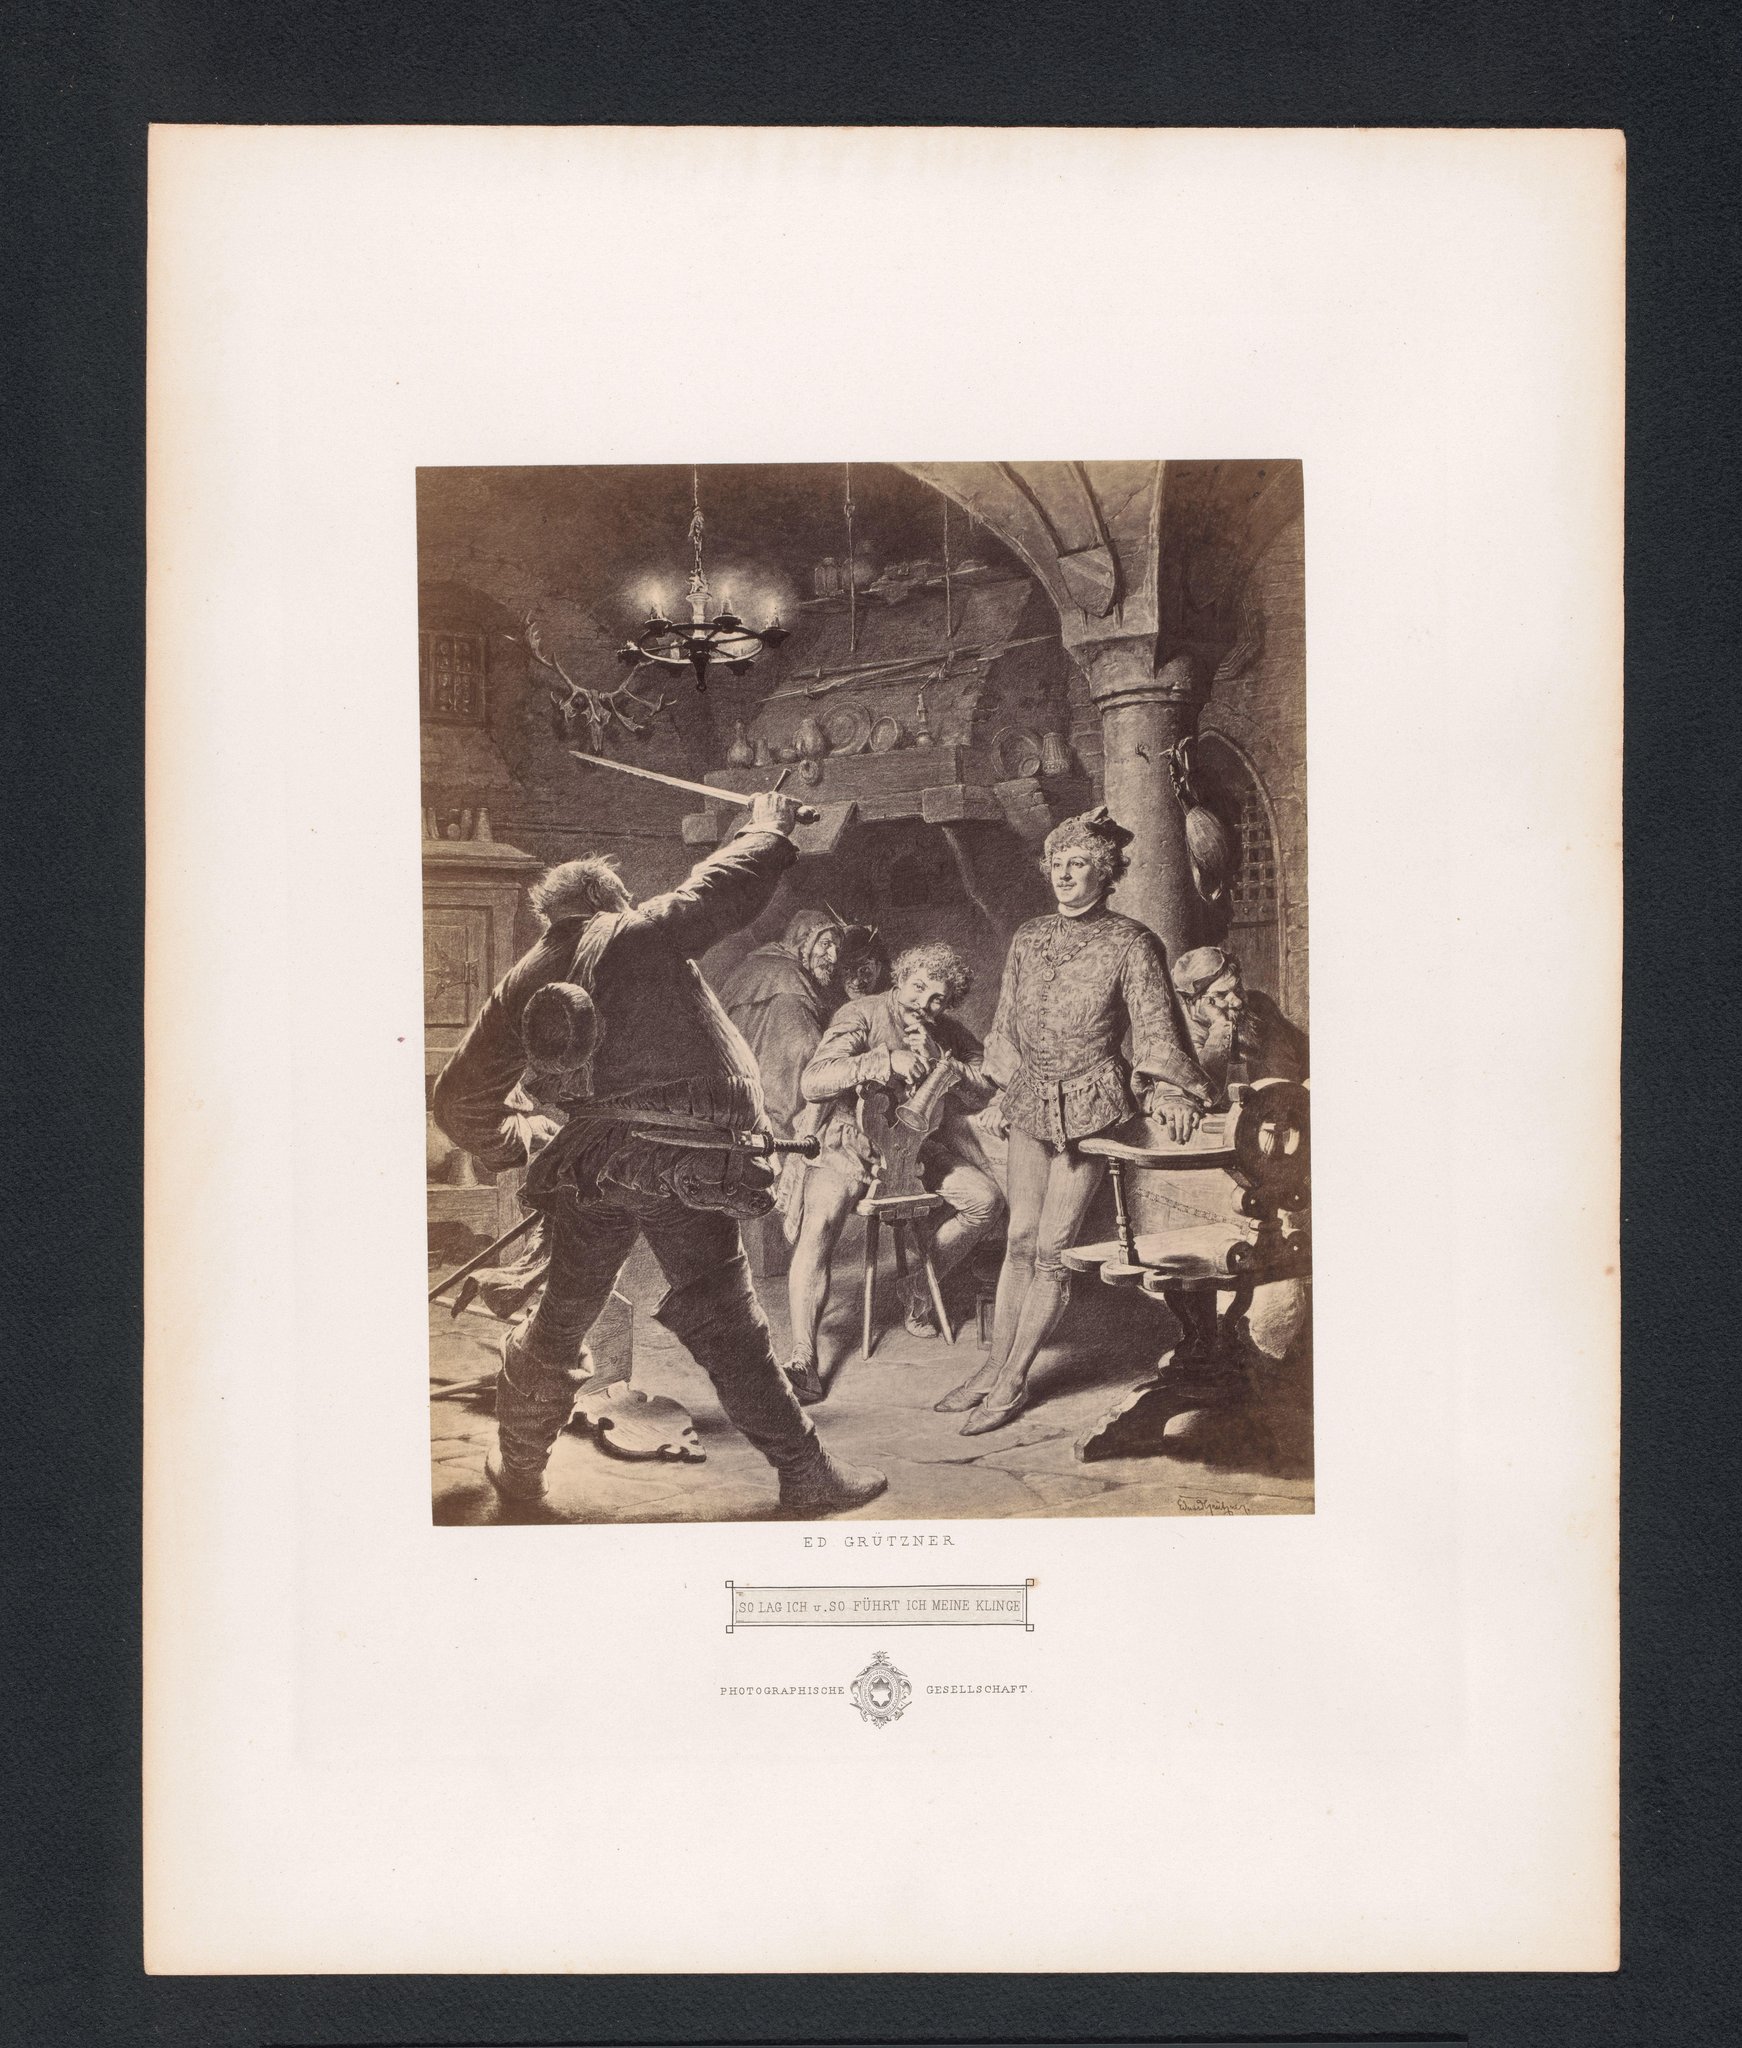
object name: reproduction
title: So Lag Ich u. So Führt Ich Meine Klinge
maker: eduard von grützner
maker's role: painter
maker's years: 1846-1925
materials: photographic support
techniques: albumen print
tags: specific works of literature, falstaff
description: Deze foto maakt deel uit van een omslag met zeven foto's, een titelblad met foto en een tekstblad.